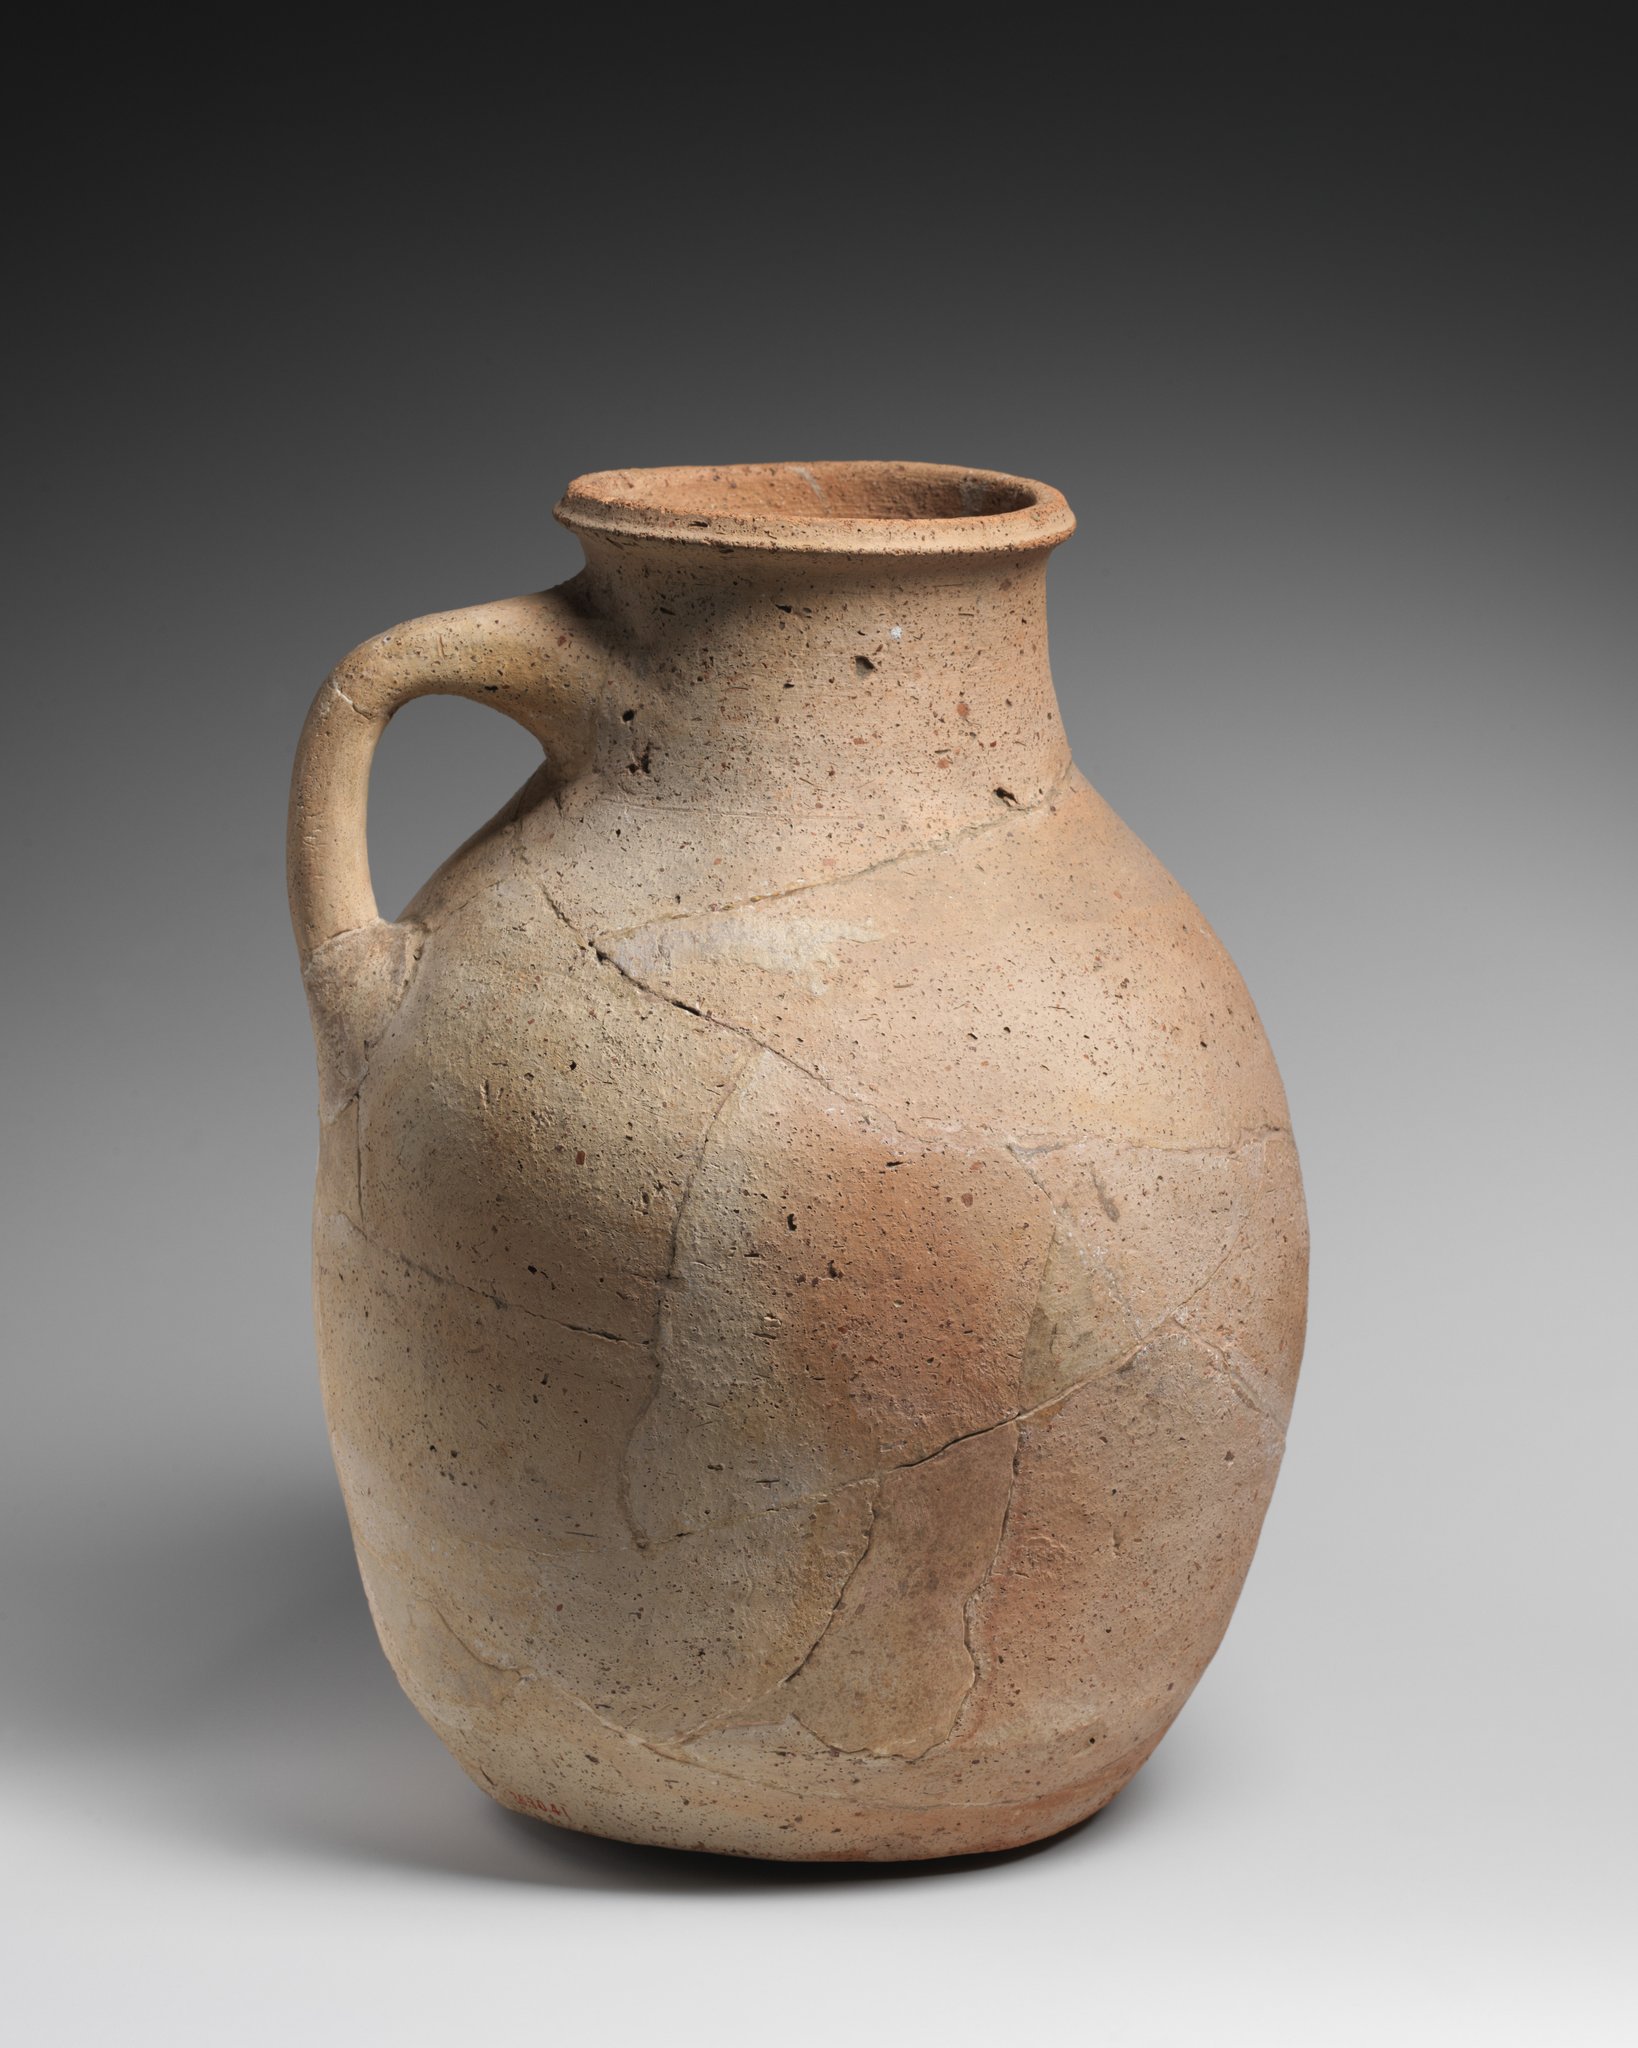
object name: jug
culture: parthian or sasanian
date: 101-400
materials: ceramic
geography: iran